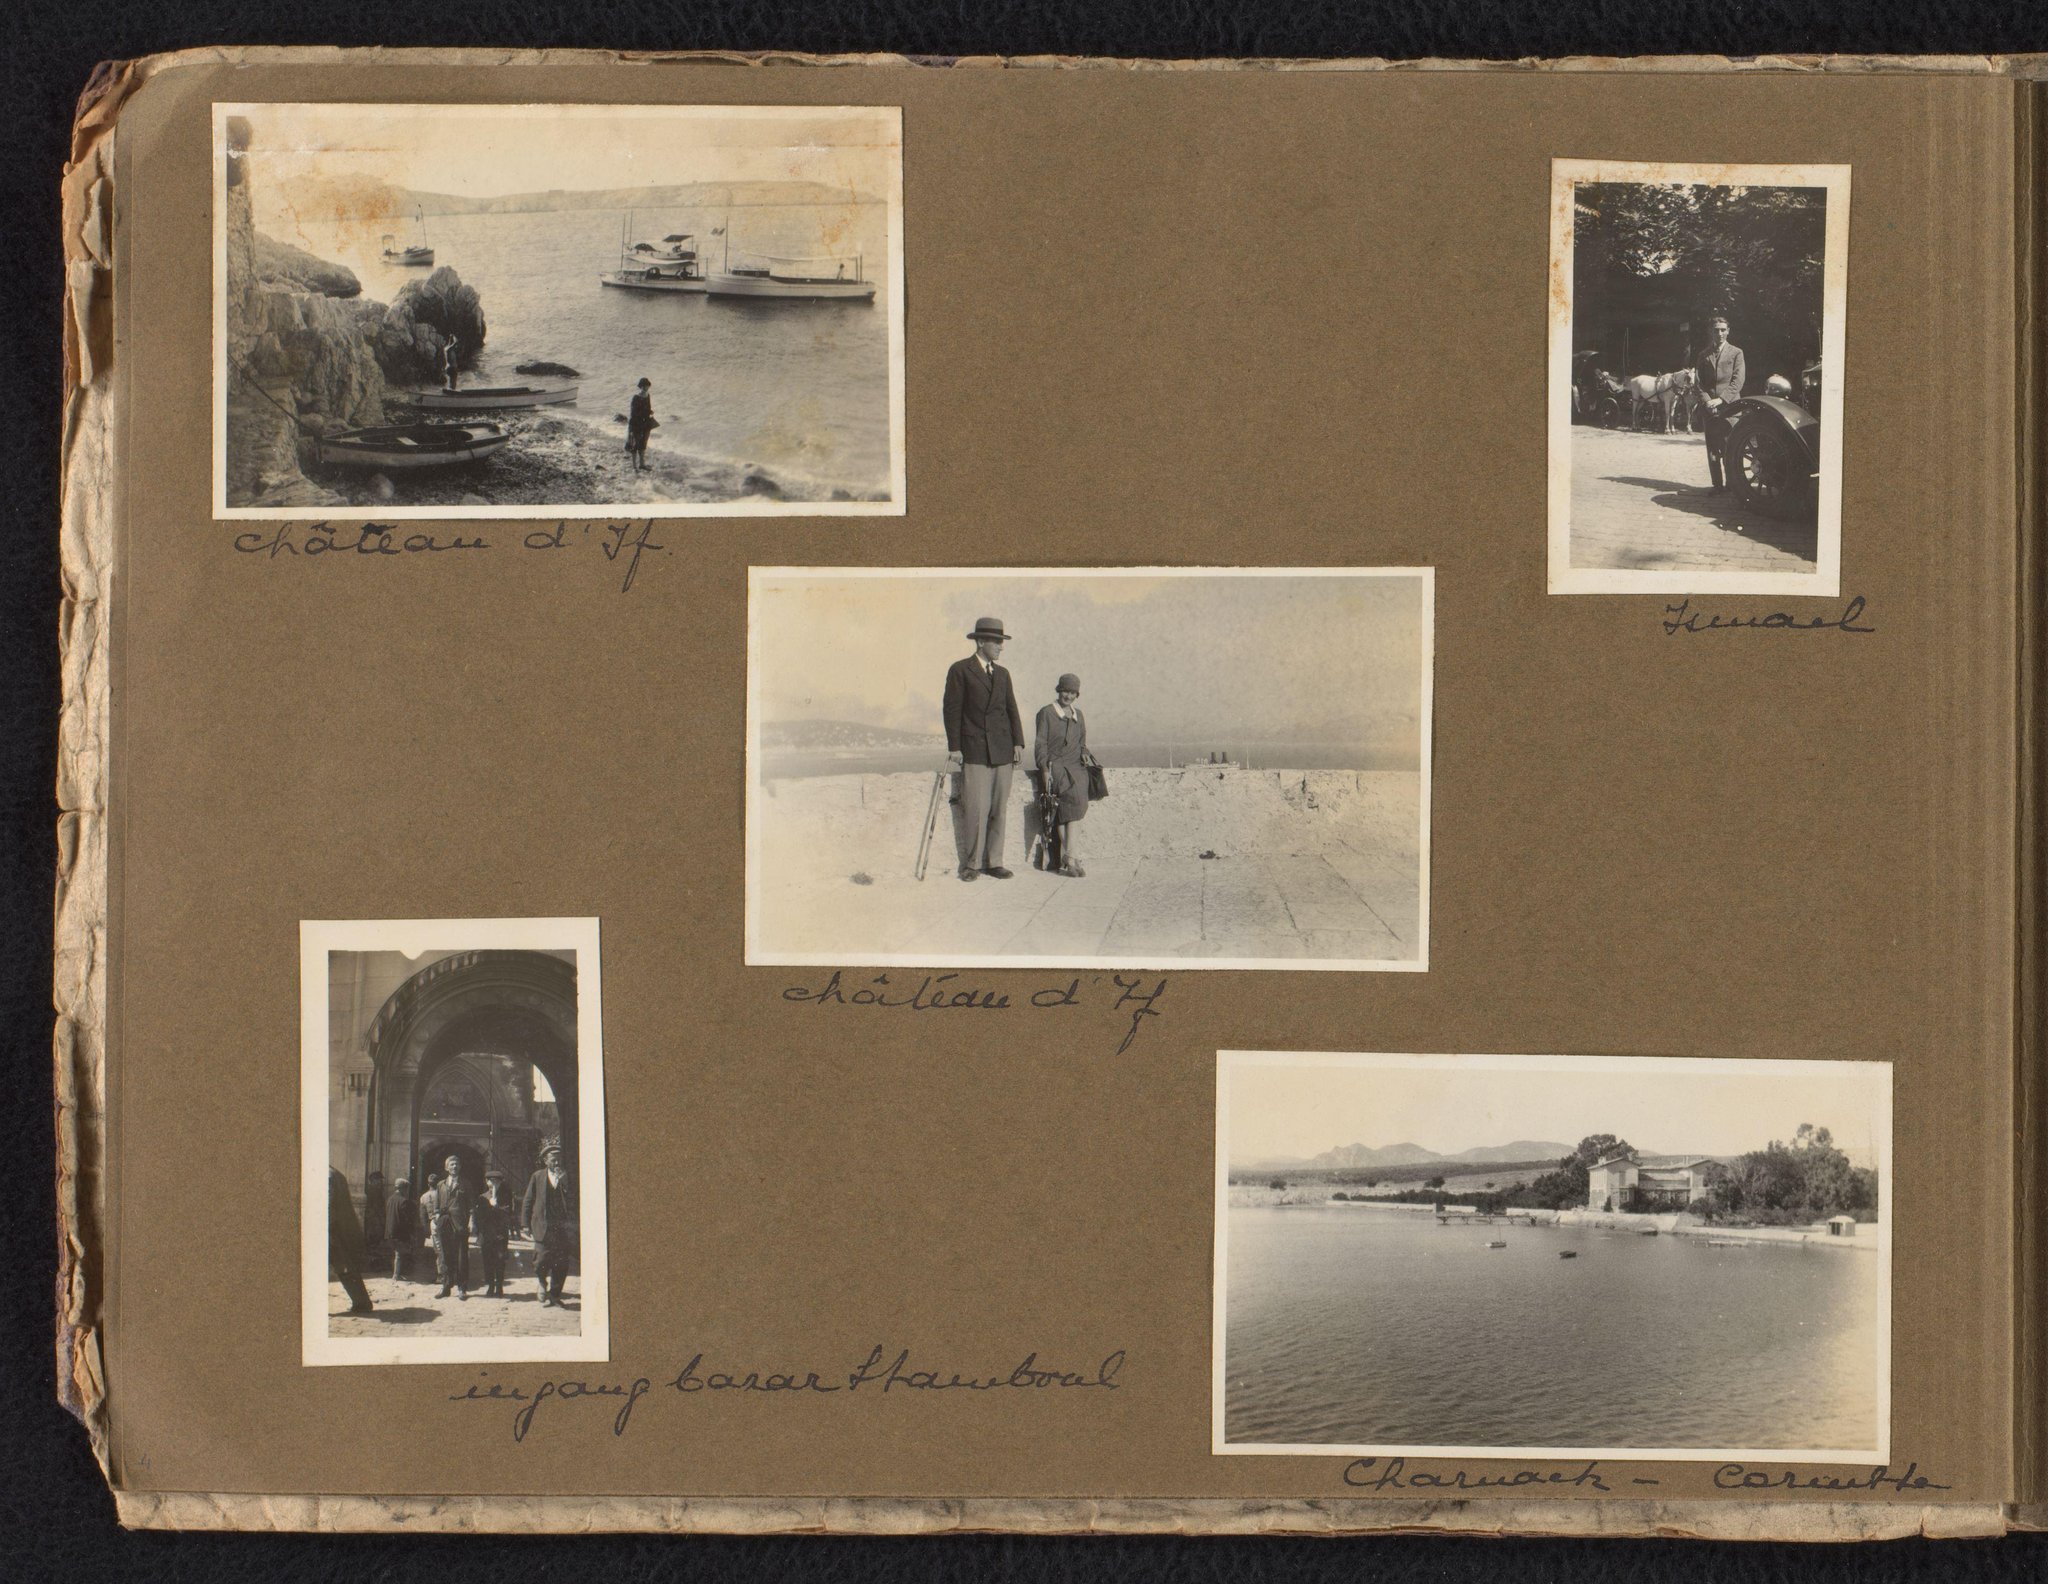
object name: photograph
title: Vijf foto's van een reis naar Marseille, Griekenland en Turkije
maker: carolina frederika onnen (lien/loen)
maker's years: 1896-1983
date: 1909-1926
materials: paper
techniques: gelatin silver print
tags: amsterdam, carolina frederika onnen (lien/loen), sightseeing, gulf, bay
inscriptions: inscription: ‘Charnach - Corinthe’, inscription: ‘Ismael’, inscription: ‘ingang bazar Stamboul’, inscription: ‘château d'If’, inscription: ‘Château d'If’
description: Deze foto's maken deel uit van een album.